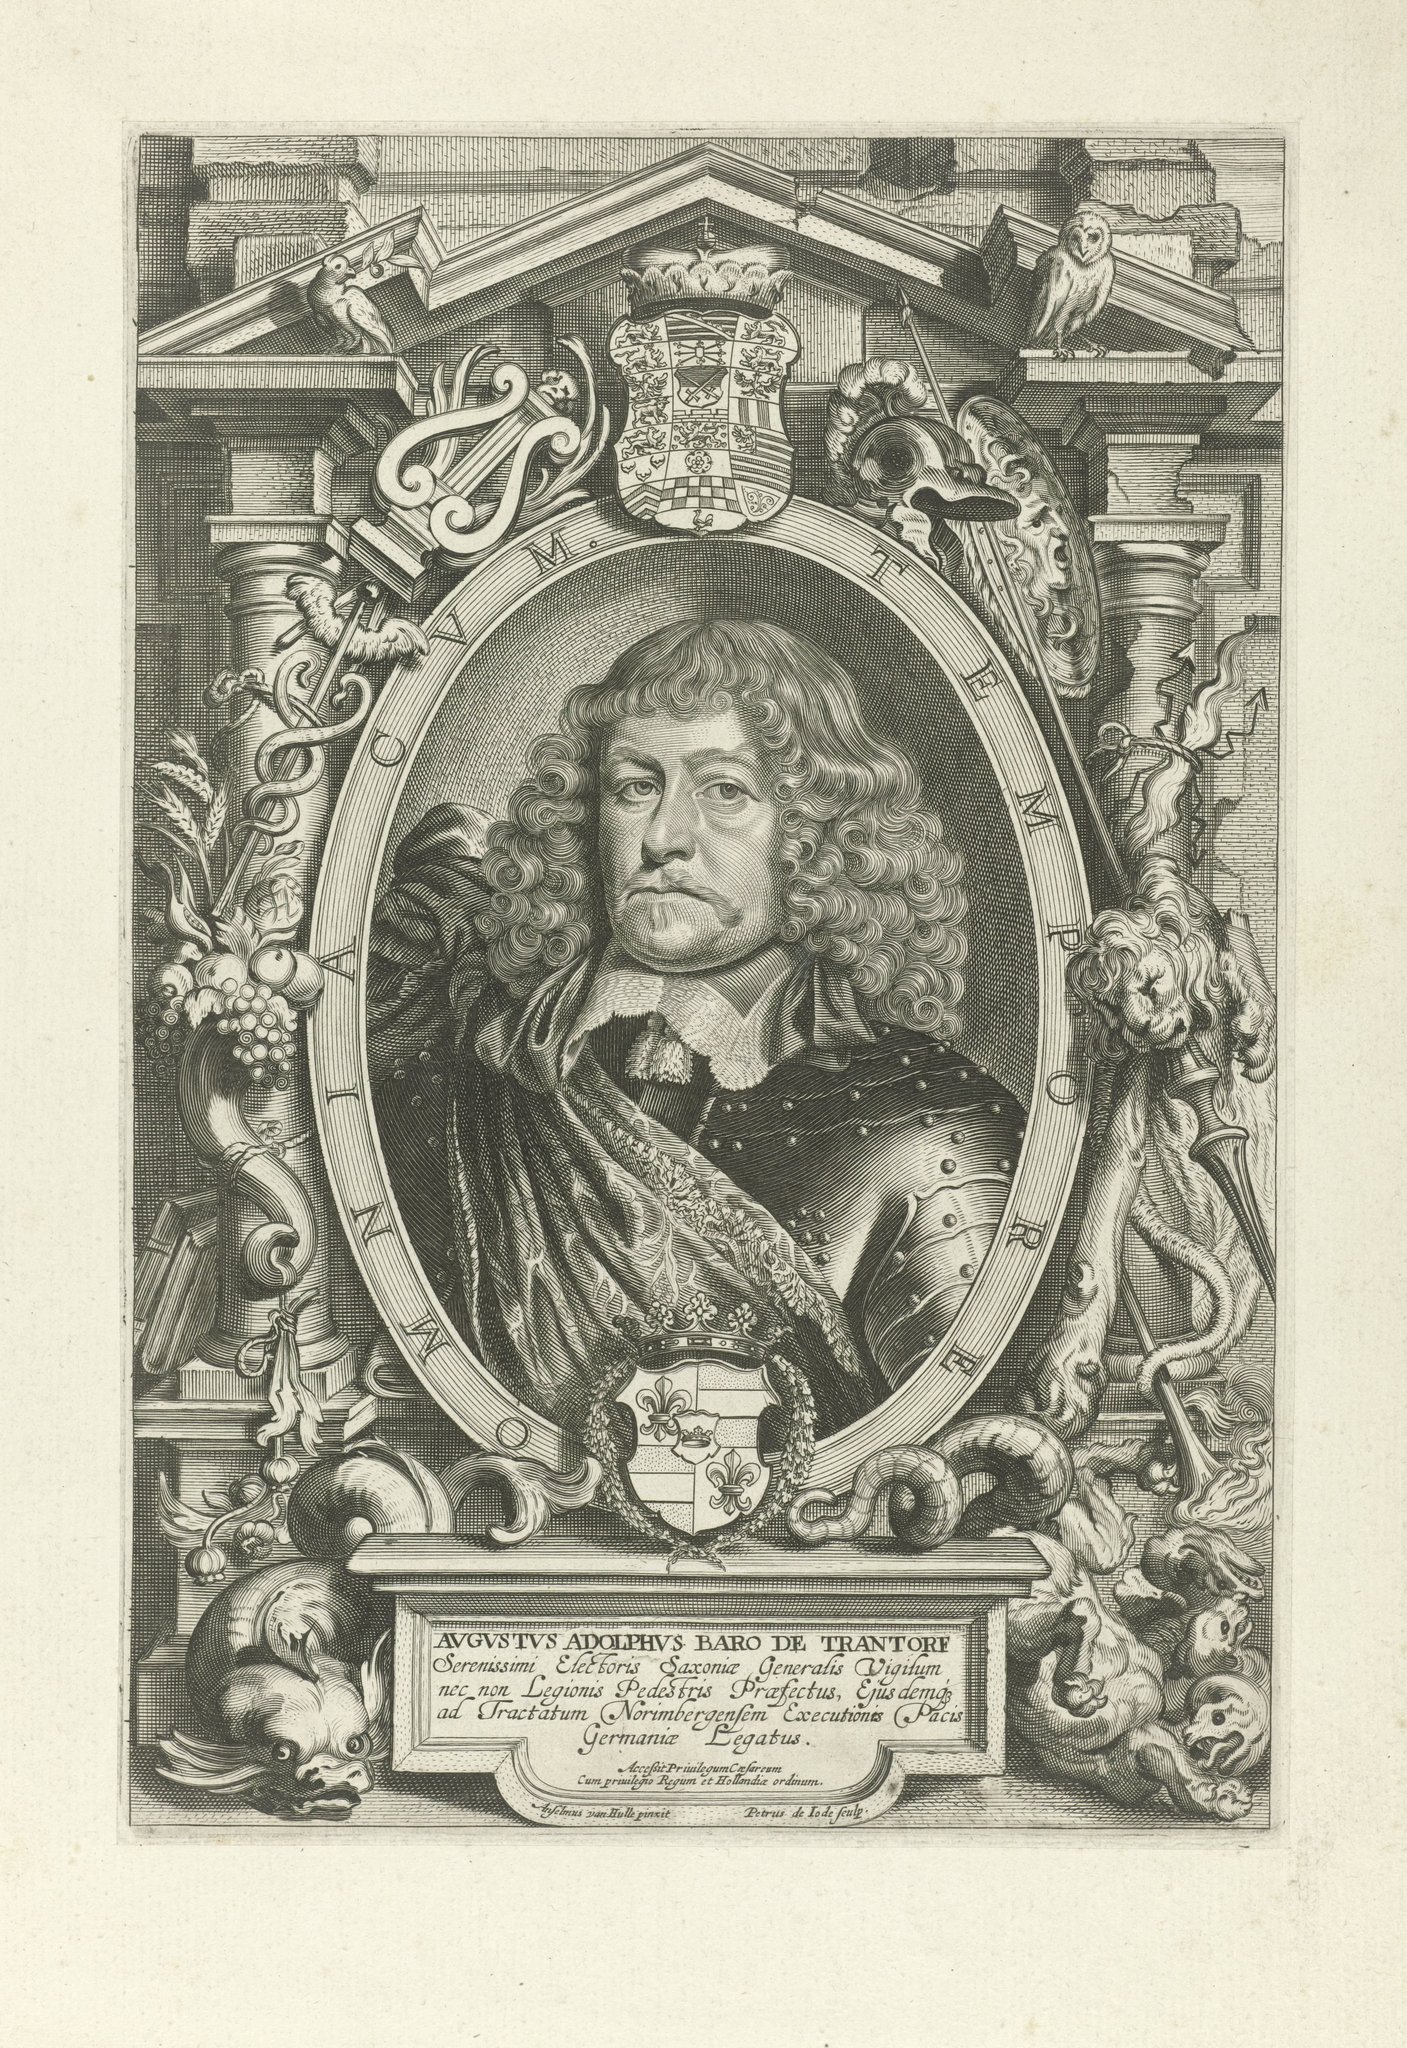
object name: print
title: Portret van August Adolf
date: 1628-1670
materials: paper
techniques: engraving, etching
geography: antwerp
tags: attributes of apollo: lyre, attributes of hercules, armour, caduceus (staff with two snakes, attribute of mercury), attributes of mars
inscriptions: collector's mark: Lugt 2228a, collector's mark: Lugt 2228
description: Busteportret van August Adolf, baron van Trantorf, in harnas. Het portret is gevat in een ovale omlijsting met het wapenschild van de geportretteerde en een randschrift in het Latijn. Op het fronton een duif met een olijftak en een uil. Rondom de omlijsting diverse decoraties waaronder attributen van Mercurius, Apollo, Mars en Hercules. Prent uit een serie portretten naar schilderijen van Anselmus van Hulle van alle gedelegeerden bij de vredesonderhandelingen te Münster en Osnabrück.